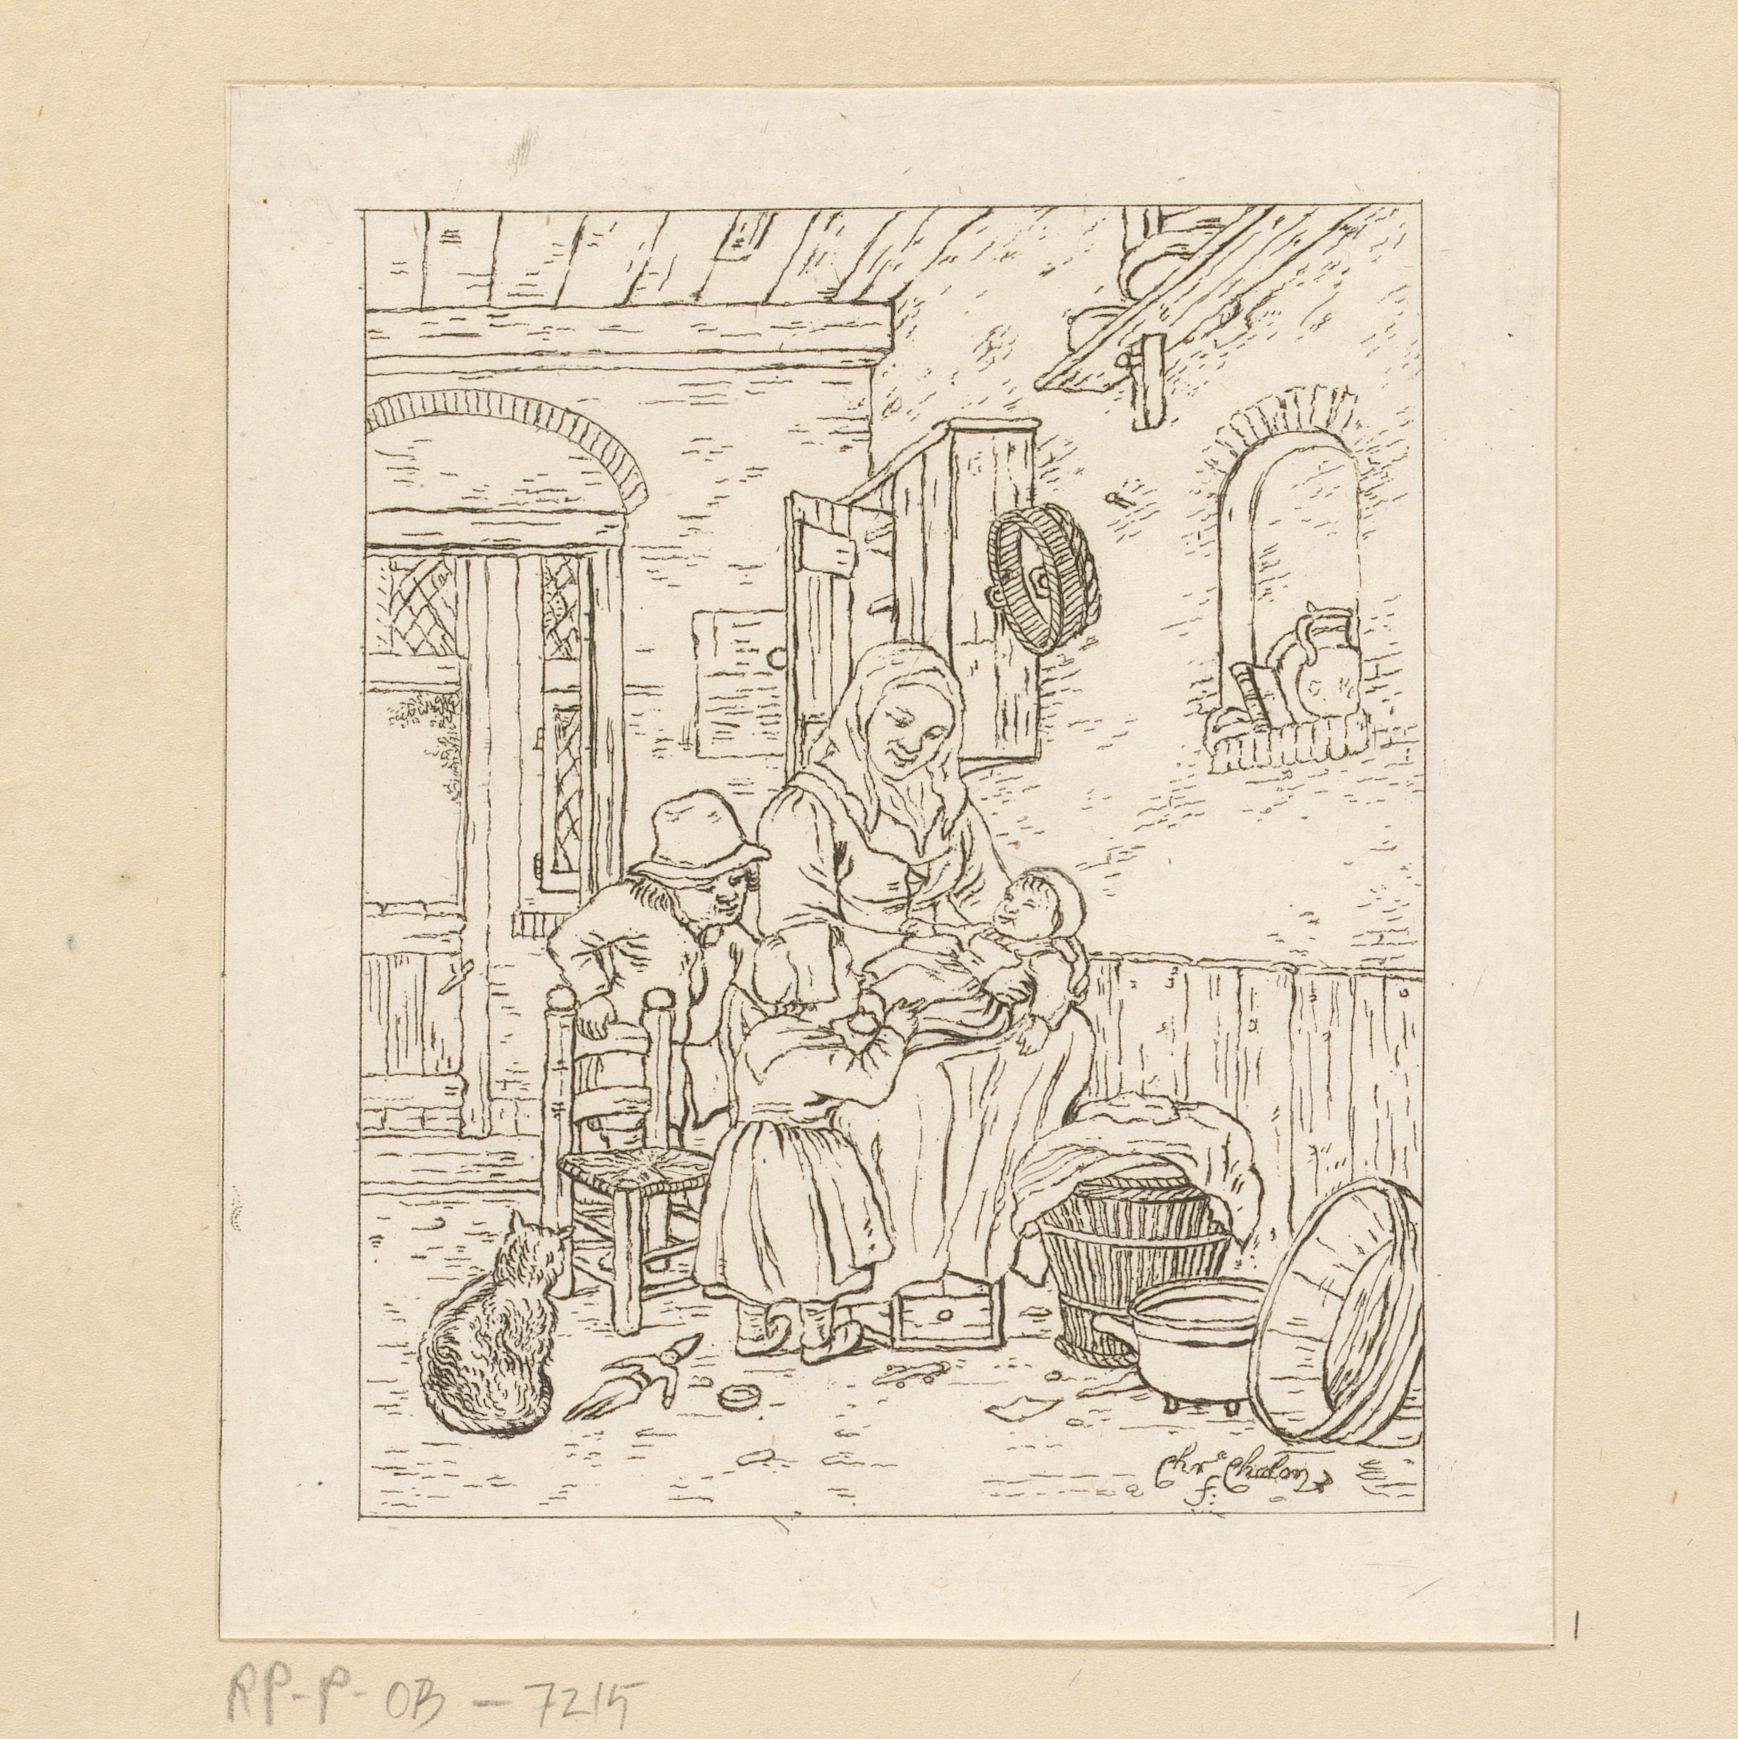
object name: print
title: Moeder met kinderen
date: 1779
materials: paper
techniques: etching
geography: leiden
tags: cat, mother and child(ren), woman and child(ren) (family group) (with number of children), rocking the baby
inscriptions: collector's mark: Lugt 2228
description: Een vrouw in een keuken. Ze zit op een stoel en draagt een baby in haar armen. Haar twee andere kinderen, een jongen en een meisje, bezichtigen het kind. Op de grond ligt wat speelgoed en een mand met wasgoed. Een kat zit links in de de hoek.